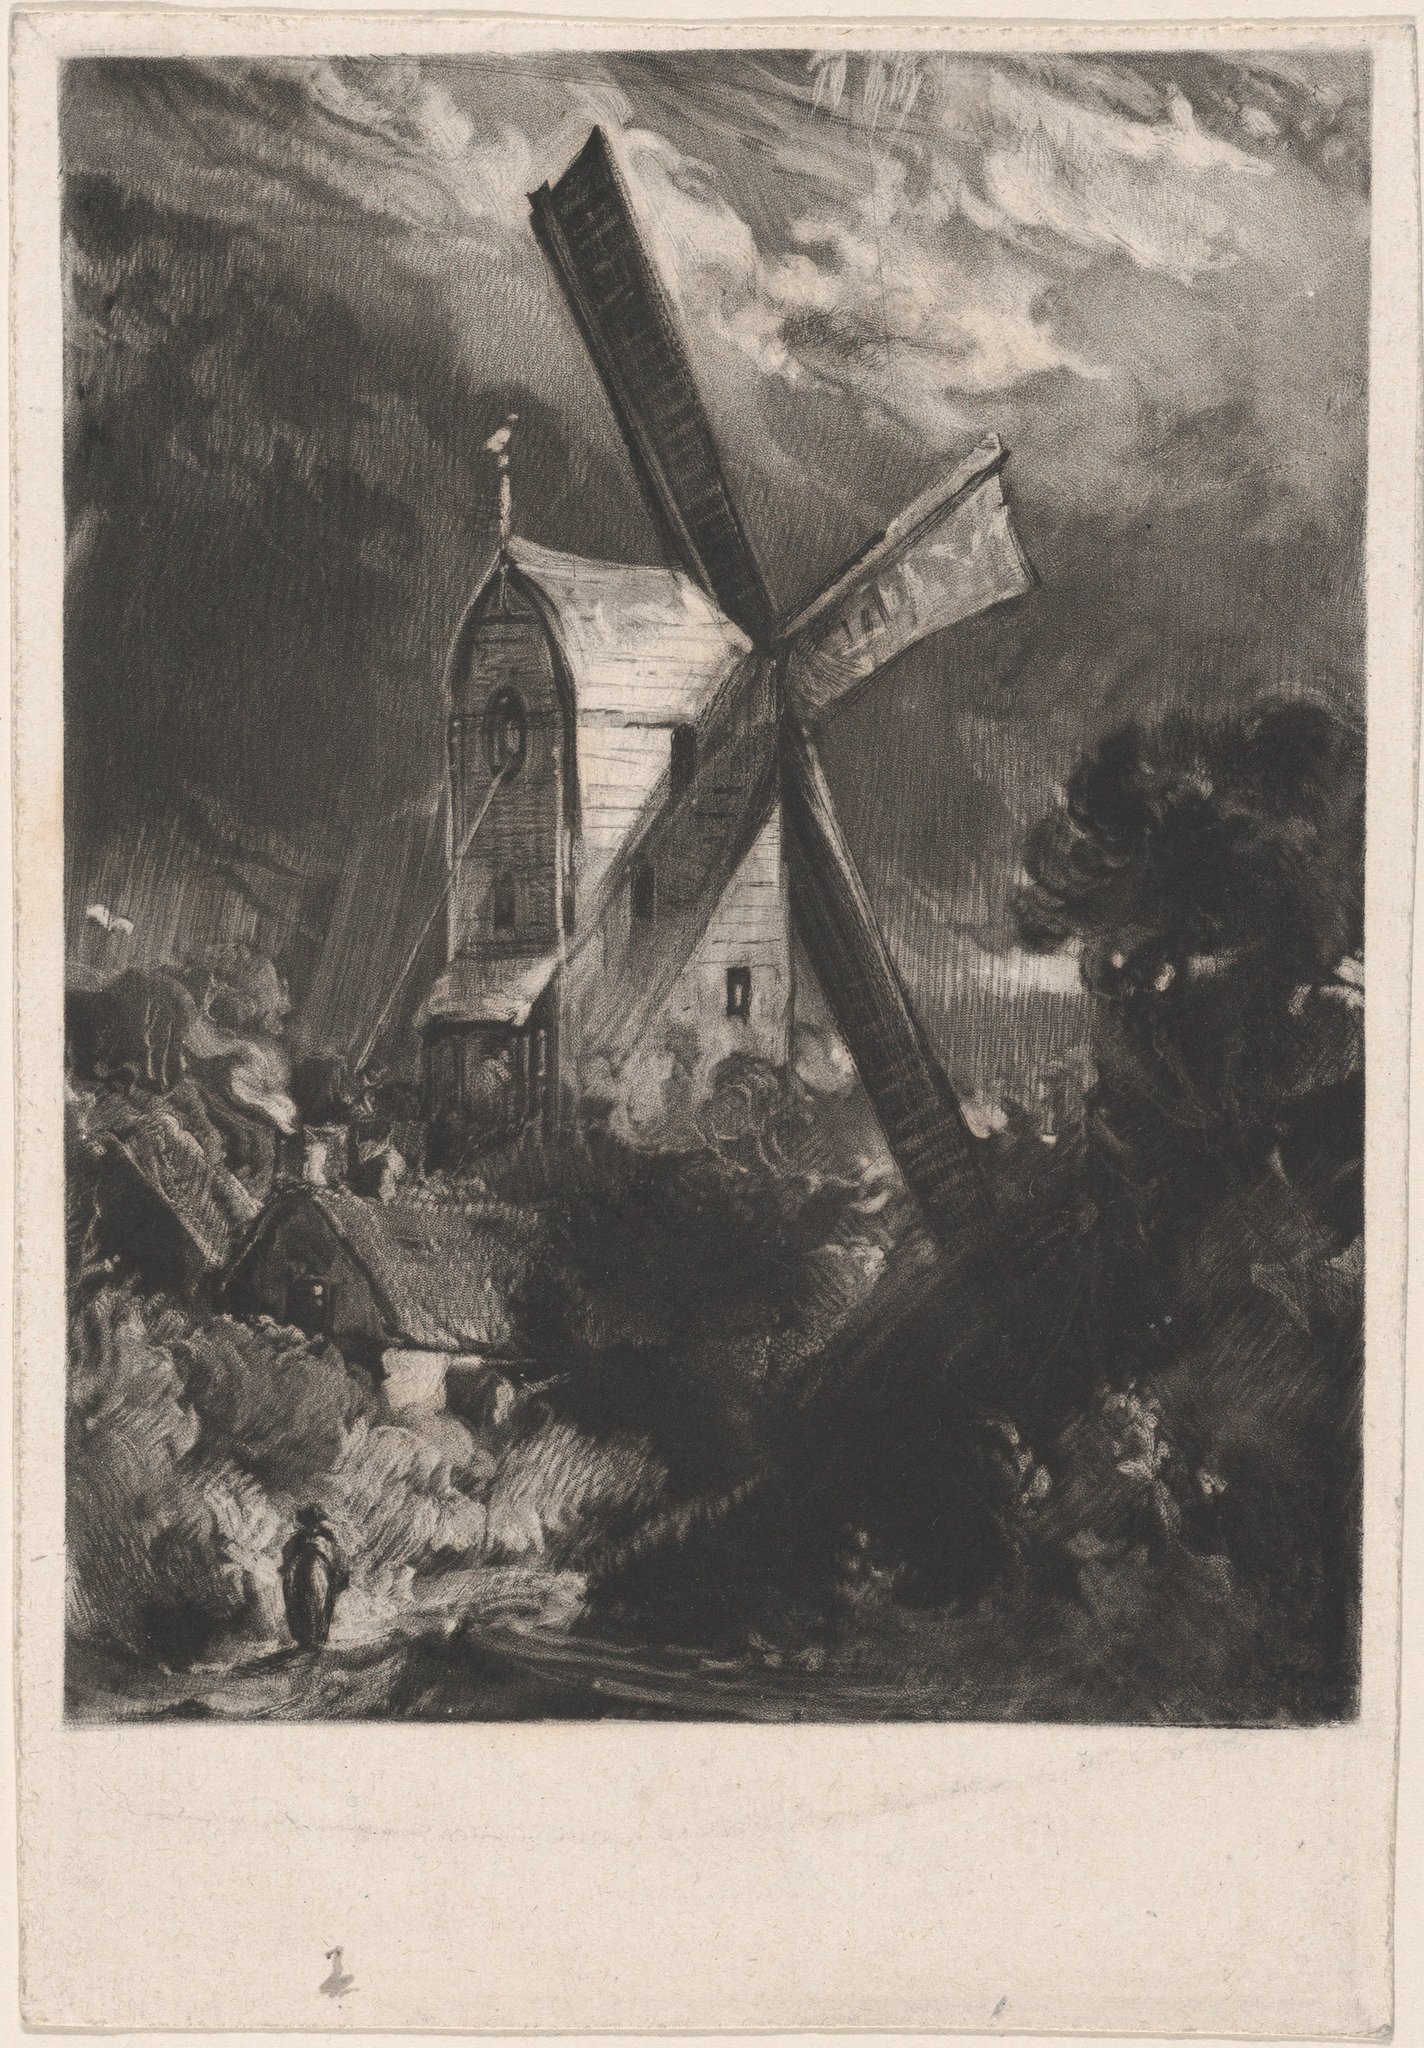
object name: print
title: Mill Near Brighton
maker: david lucas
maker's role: artist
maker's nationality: british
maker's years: 1802-1881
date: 1829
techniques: drypoint, mezzotint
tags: windmills